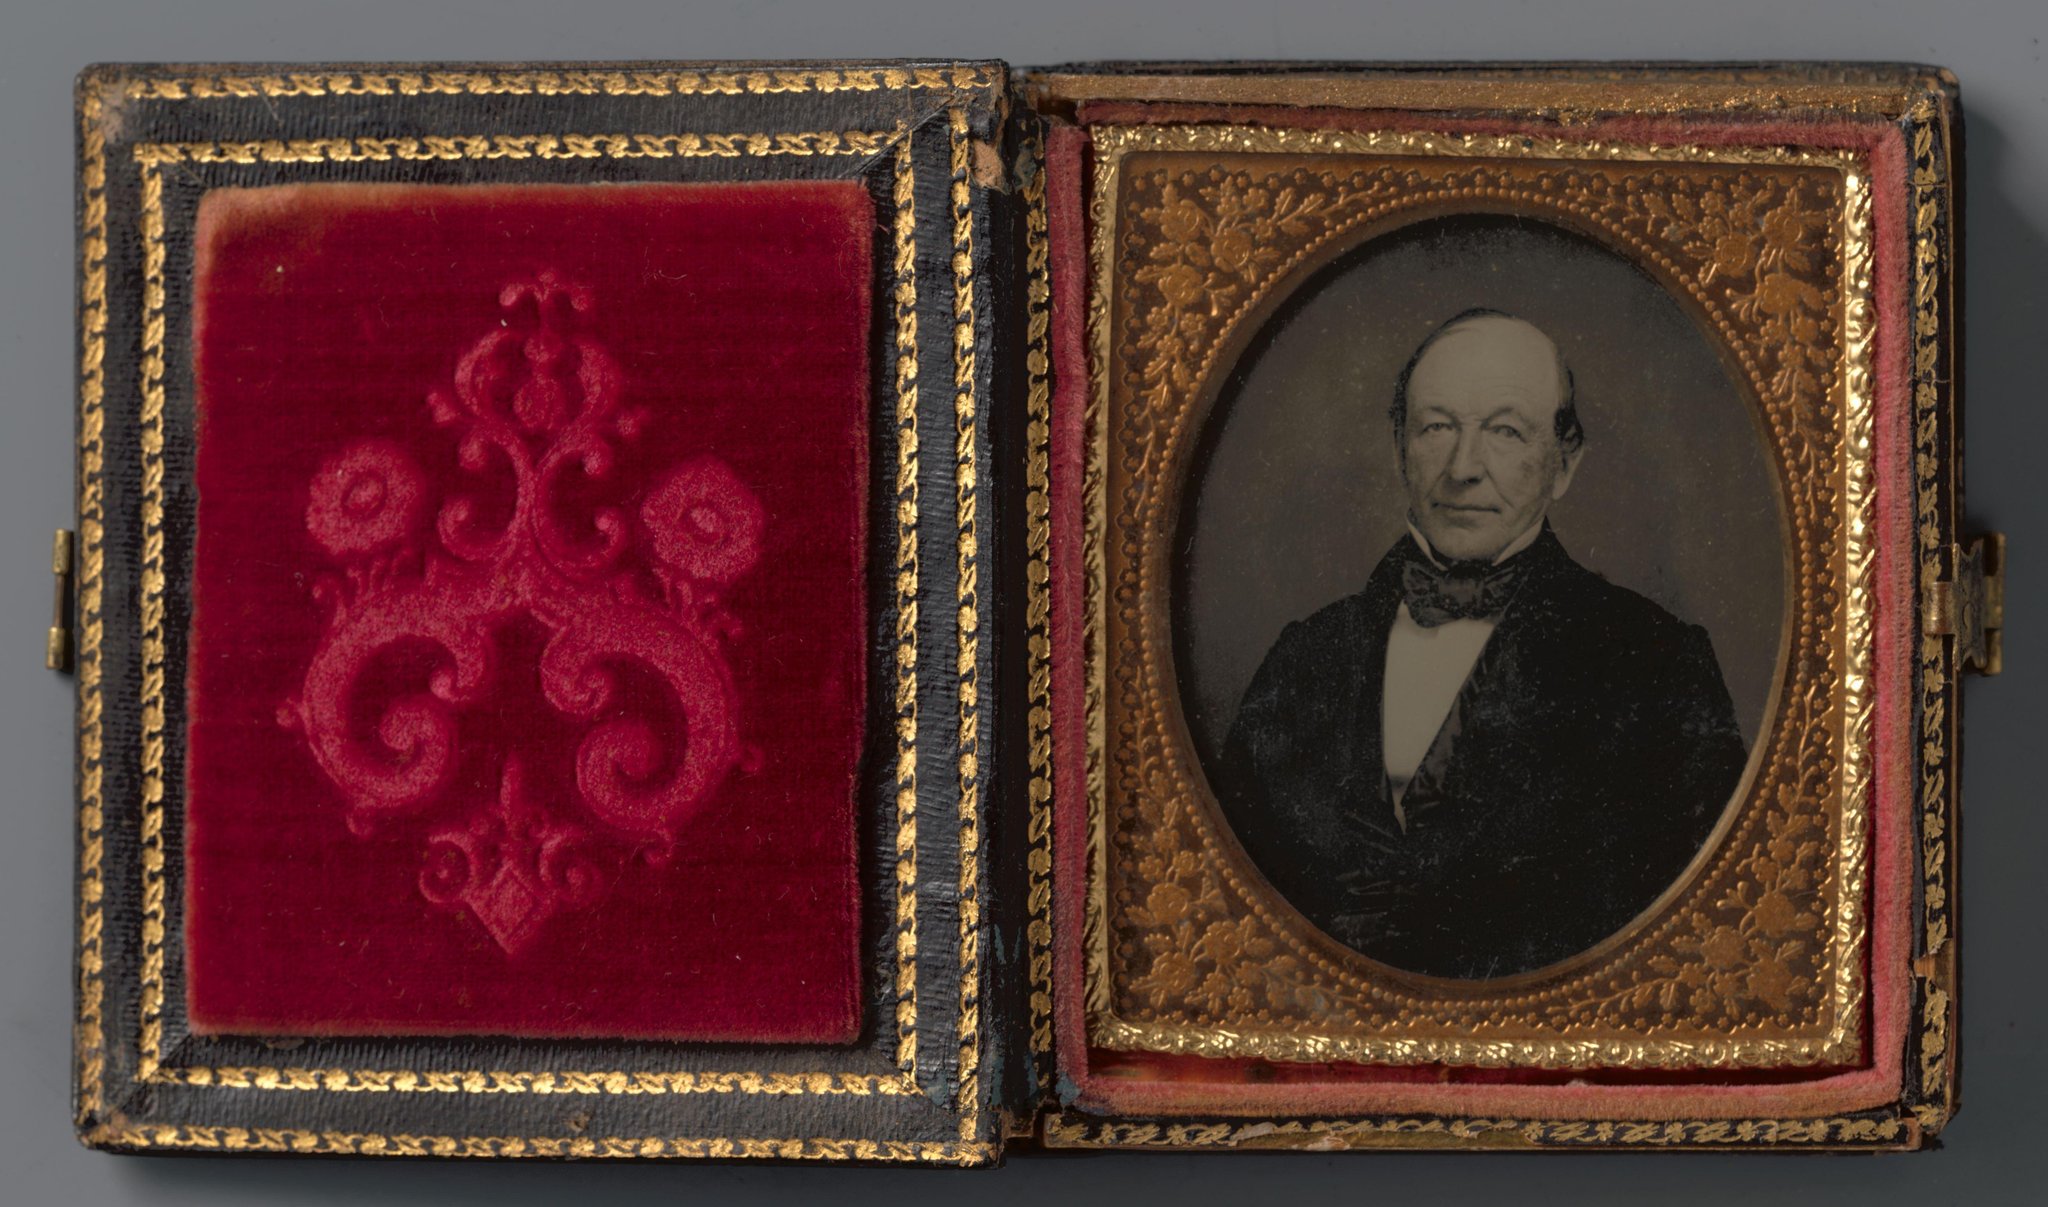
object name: photograph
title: Portret van een onbekende oude man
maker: Anonymous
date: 1856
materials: glass, leather, metal, mother of pearl, textile, wood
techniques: ambrotype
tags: historical persons, old man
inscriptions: inscription: ‘Memento’